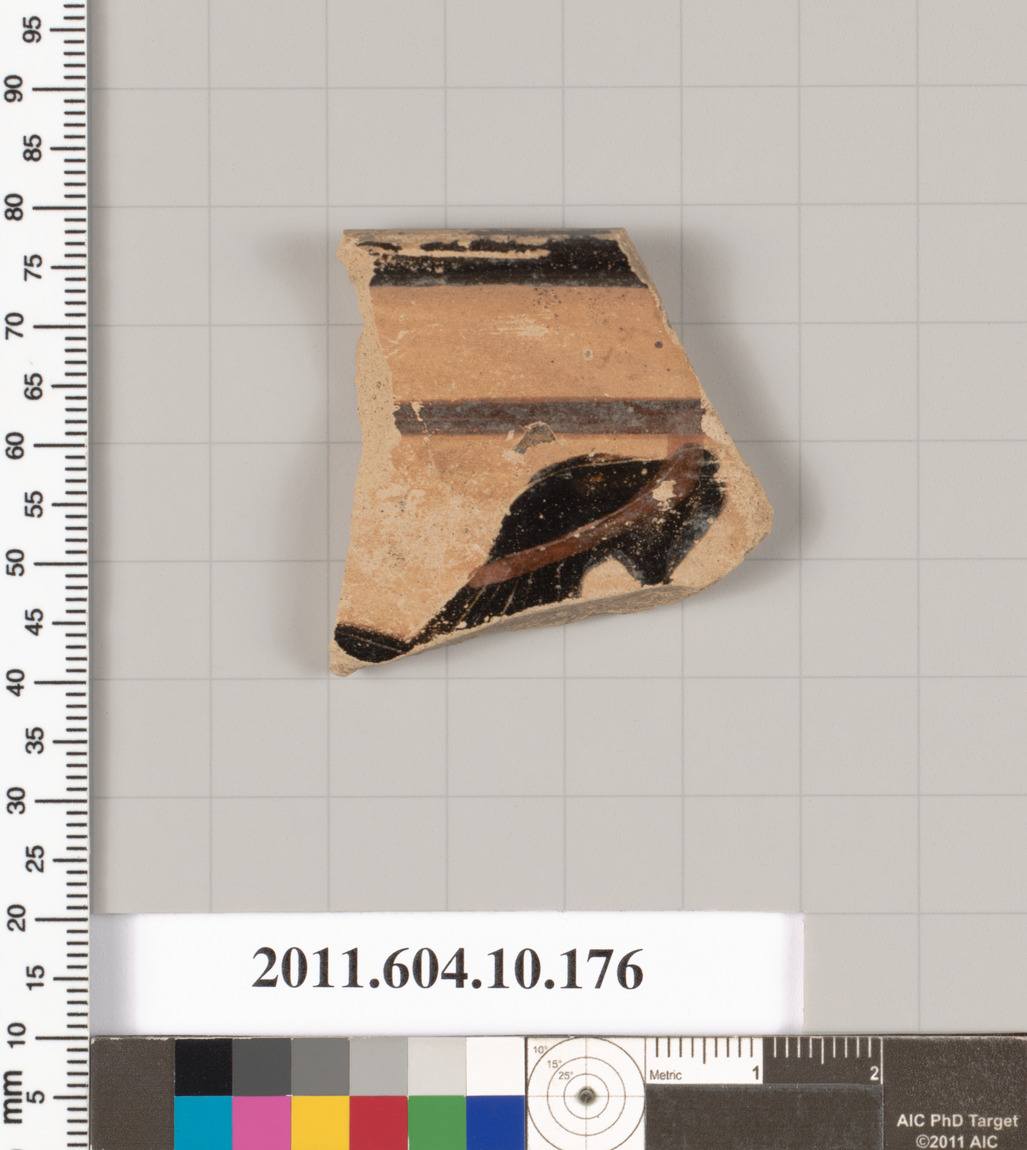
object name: skyphos fragment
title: Terracotta rim fragment of a skyphos (deep drinking cup)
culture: etruscan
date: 500-480 BCE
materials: terracotta